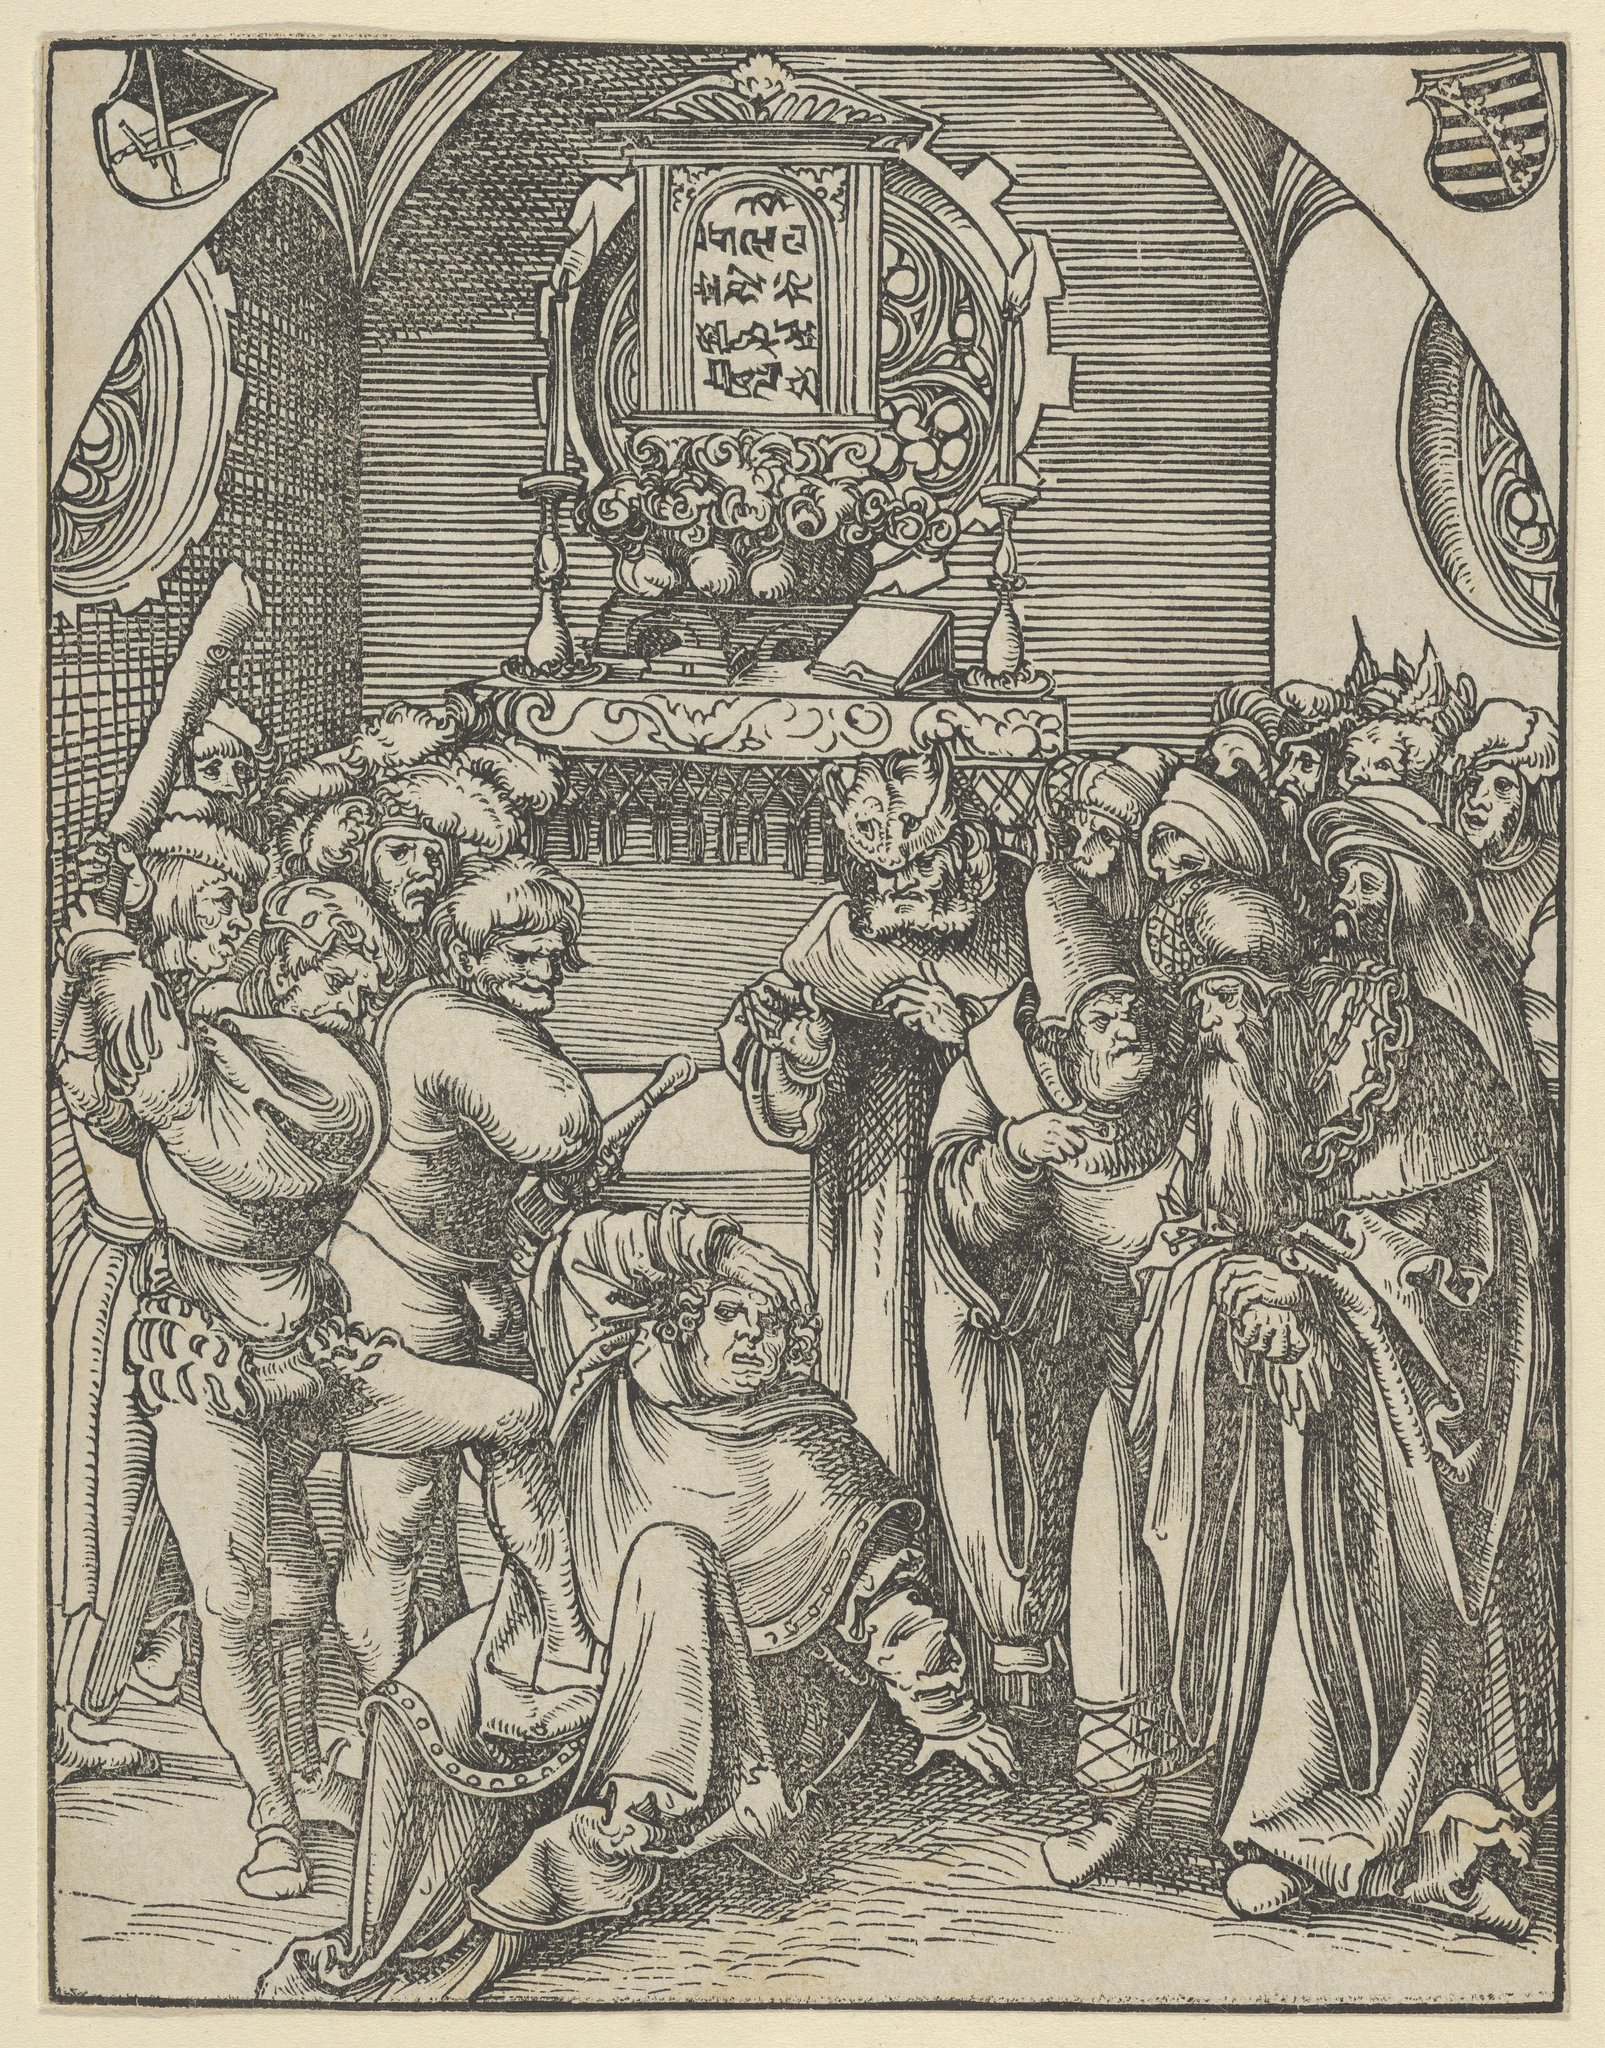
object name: print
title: Jude, from the Martyrdom of the Twelve Apostles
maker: lucas cranach the elder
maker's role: artist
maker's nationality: german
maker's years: 1472-1553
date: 1472-1553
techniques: woodcut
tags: soldiers,suffering,apostles,crowd,execution